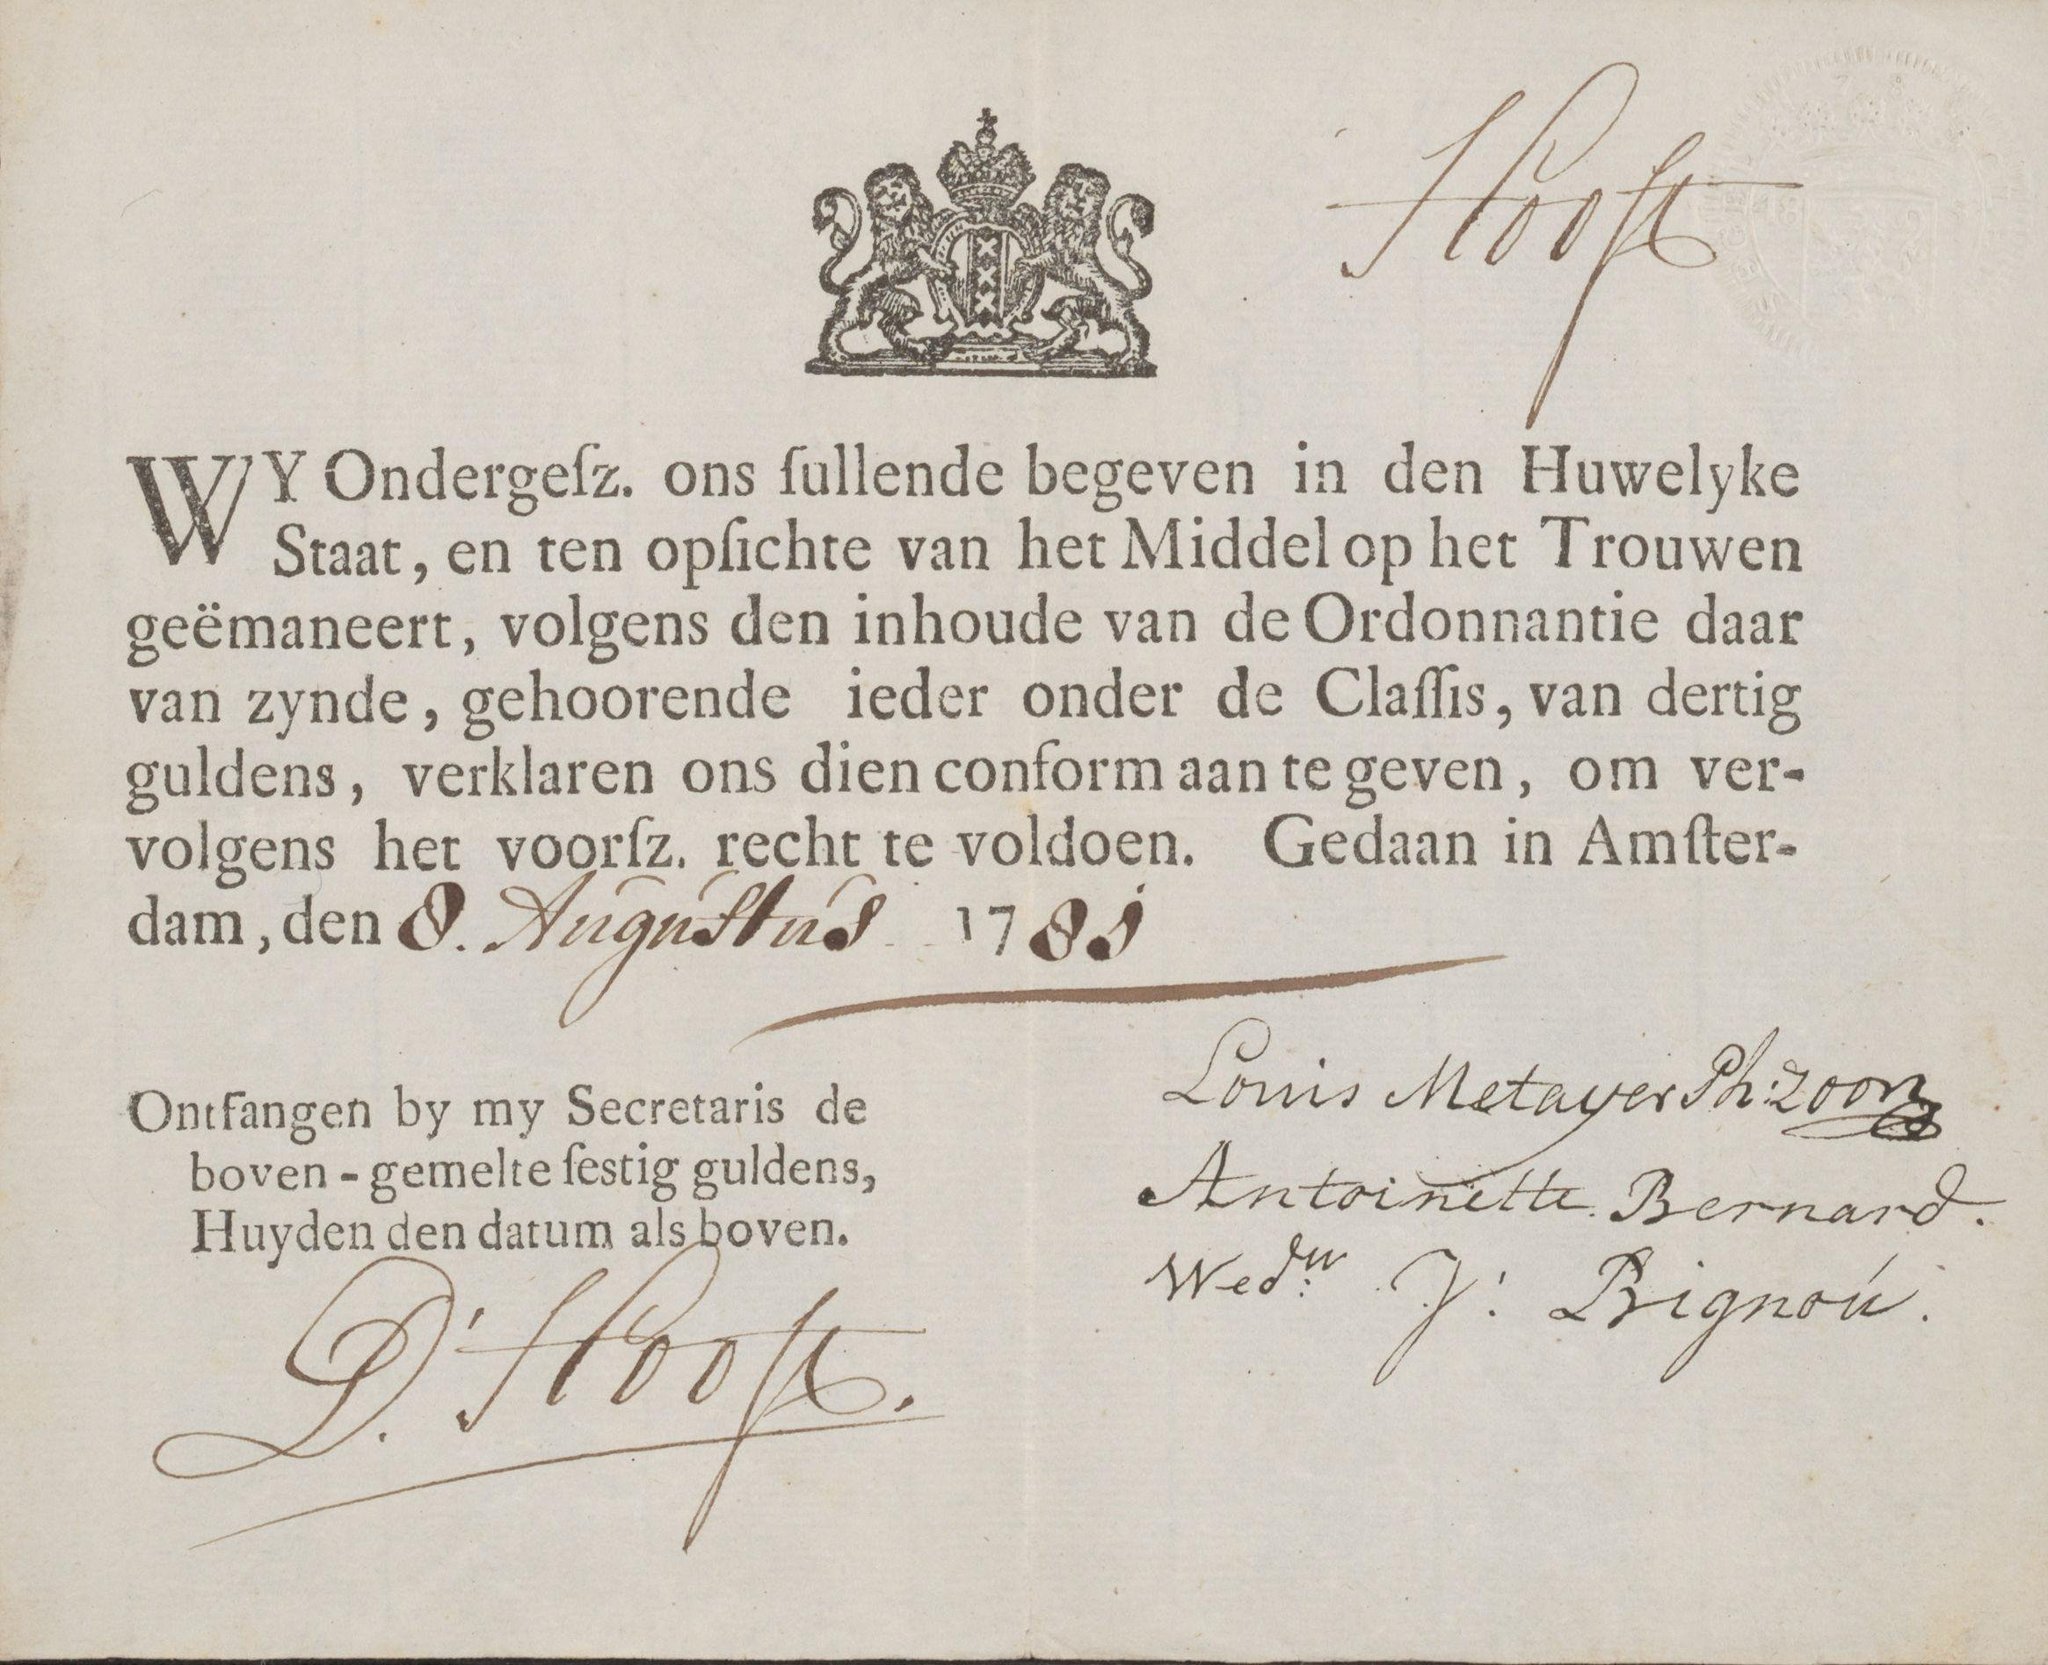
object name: document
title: Huwelijksaankondiging van Louis Metayer en Antoinette Bernard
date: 1781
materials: ink, paper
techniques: pen, printing, writing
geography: amsterdam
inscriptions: stamp: ‘CLEIN SEGEL 1781’, collector's mark: Lugt 2233, watermark